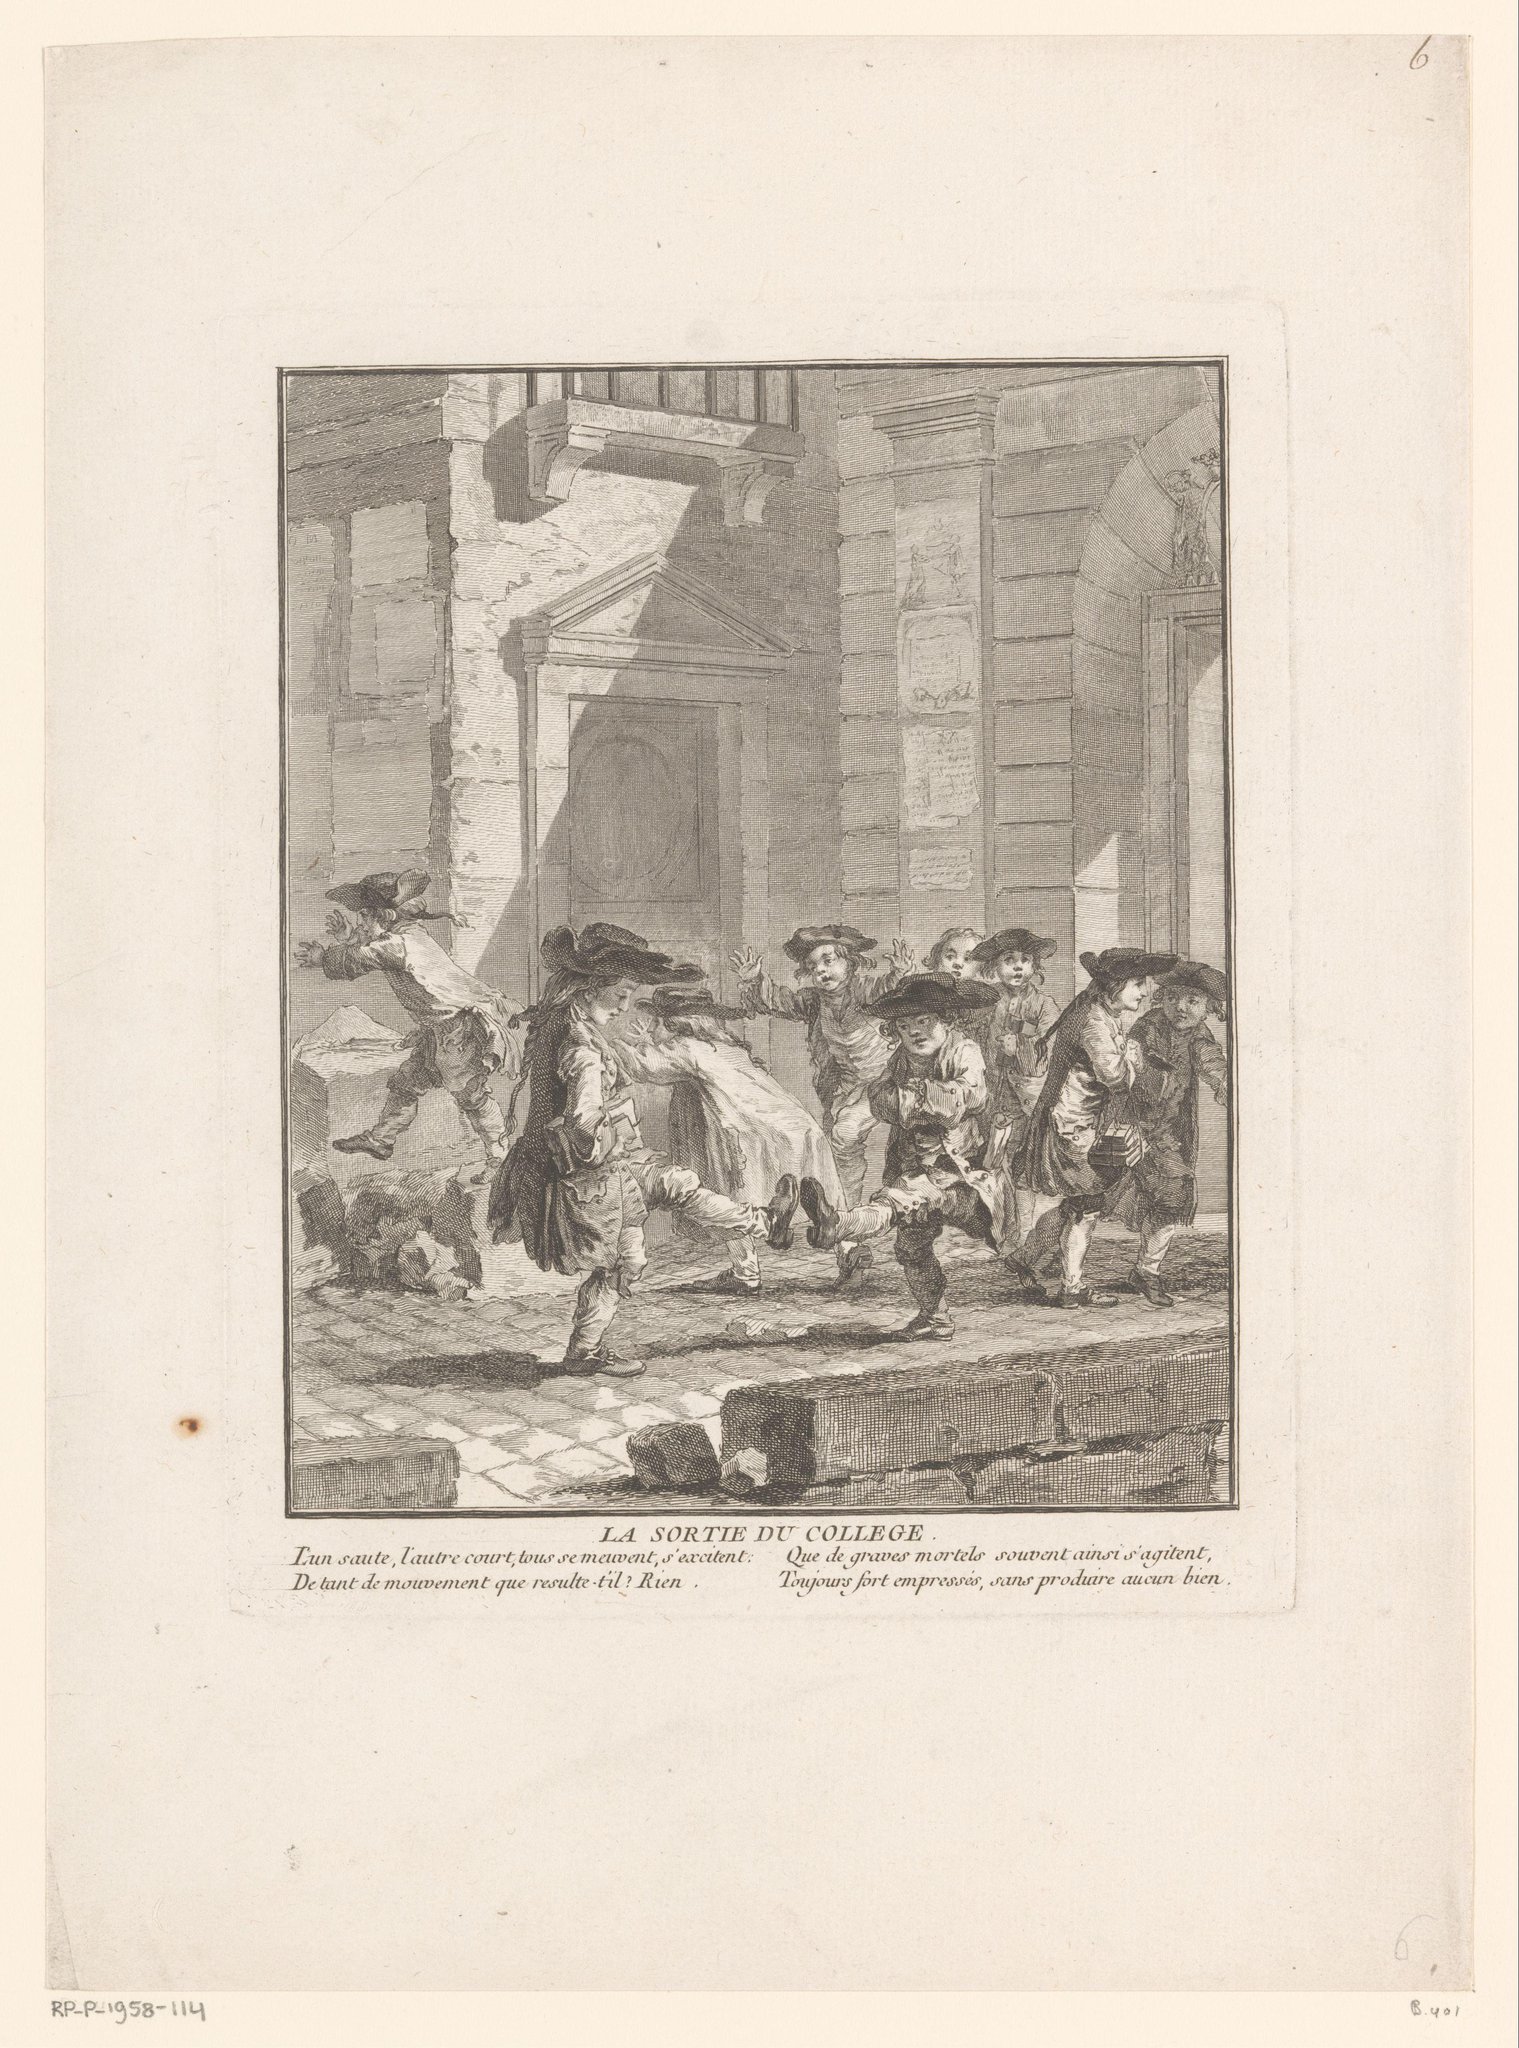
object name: print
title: La Sortie du College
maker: augustin de saint-aubin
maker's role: draughtsman, print maker, publisher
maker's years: 1736-1807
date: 1770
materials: paper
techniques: engraving, etching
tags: running games (children), scholastic education, tuition, dancing games (children's games)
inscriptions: collector's mark: Lugt 2228, collector's mark: Lugt 2760, collector's mark: Lugt 533b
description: Prent maakt deel uit van een ongenummerde serie van zes prenten.